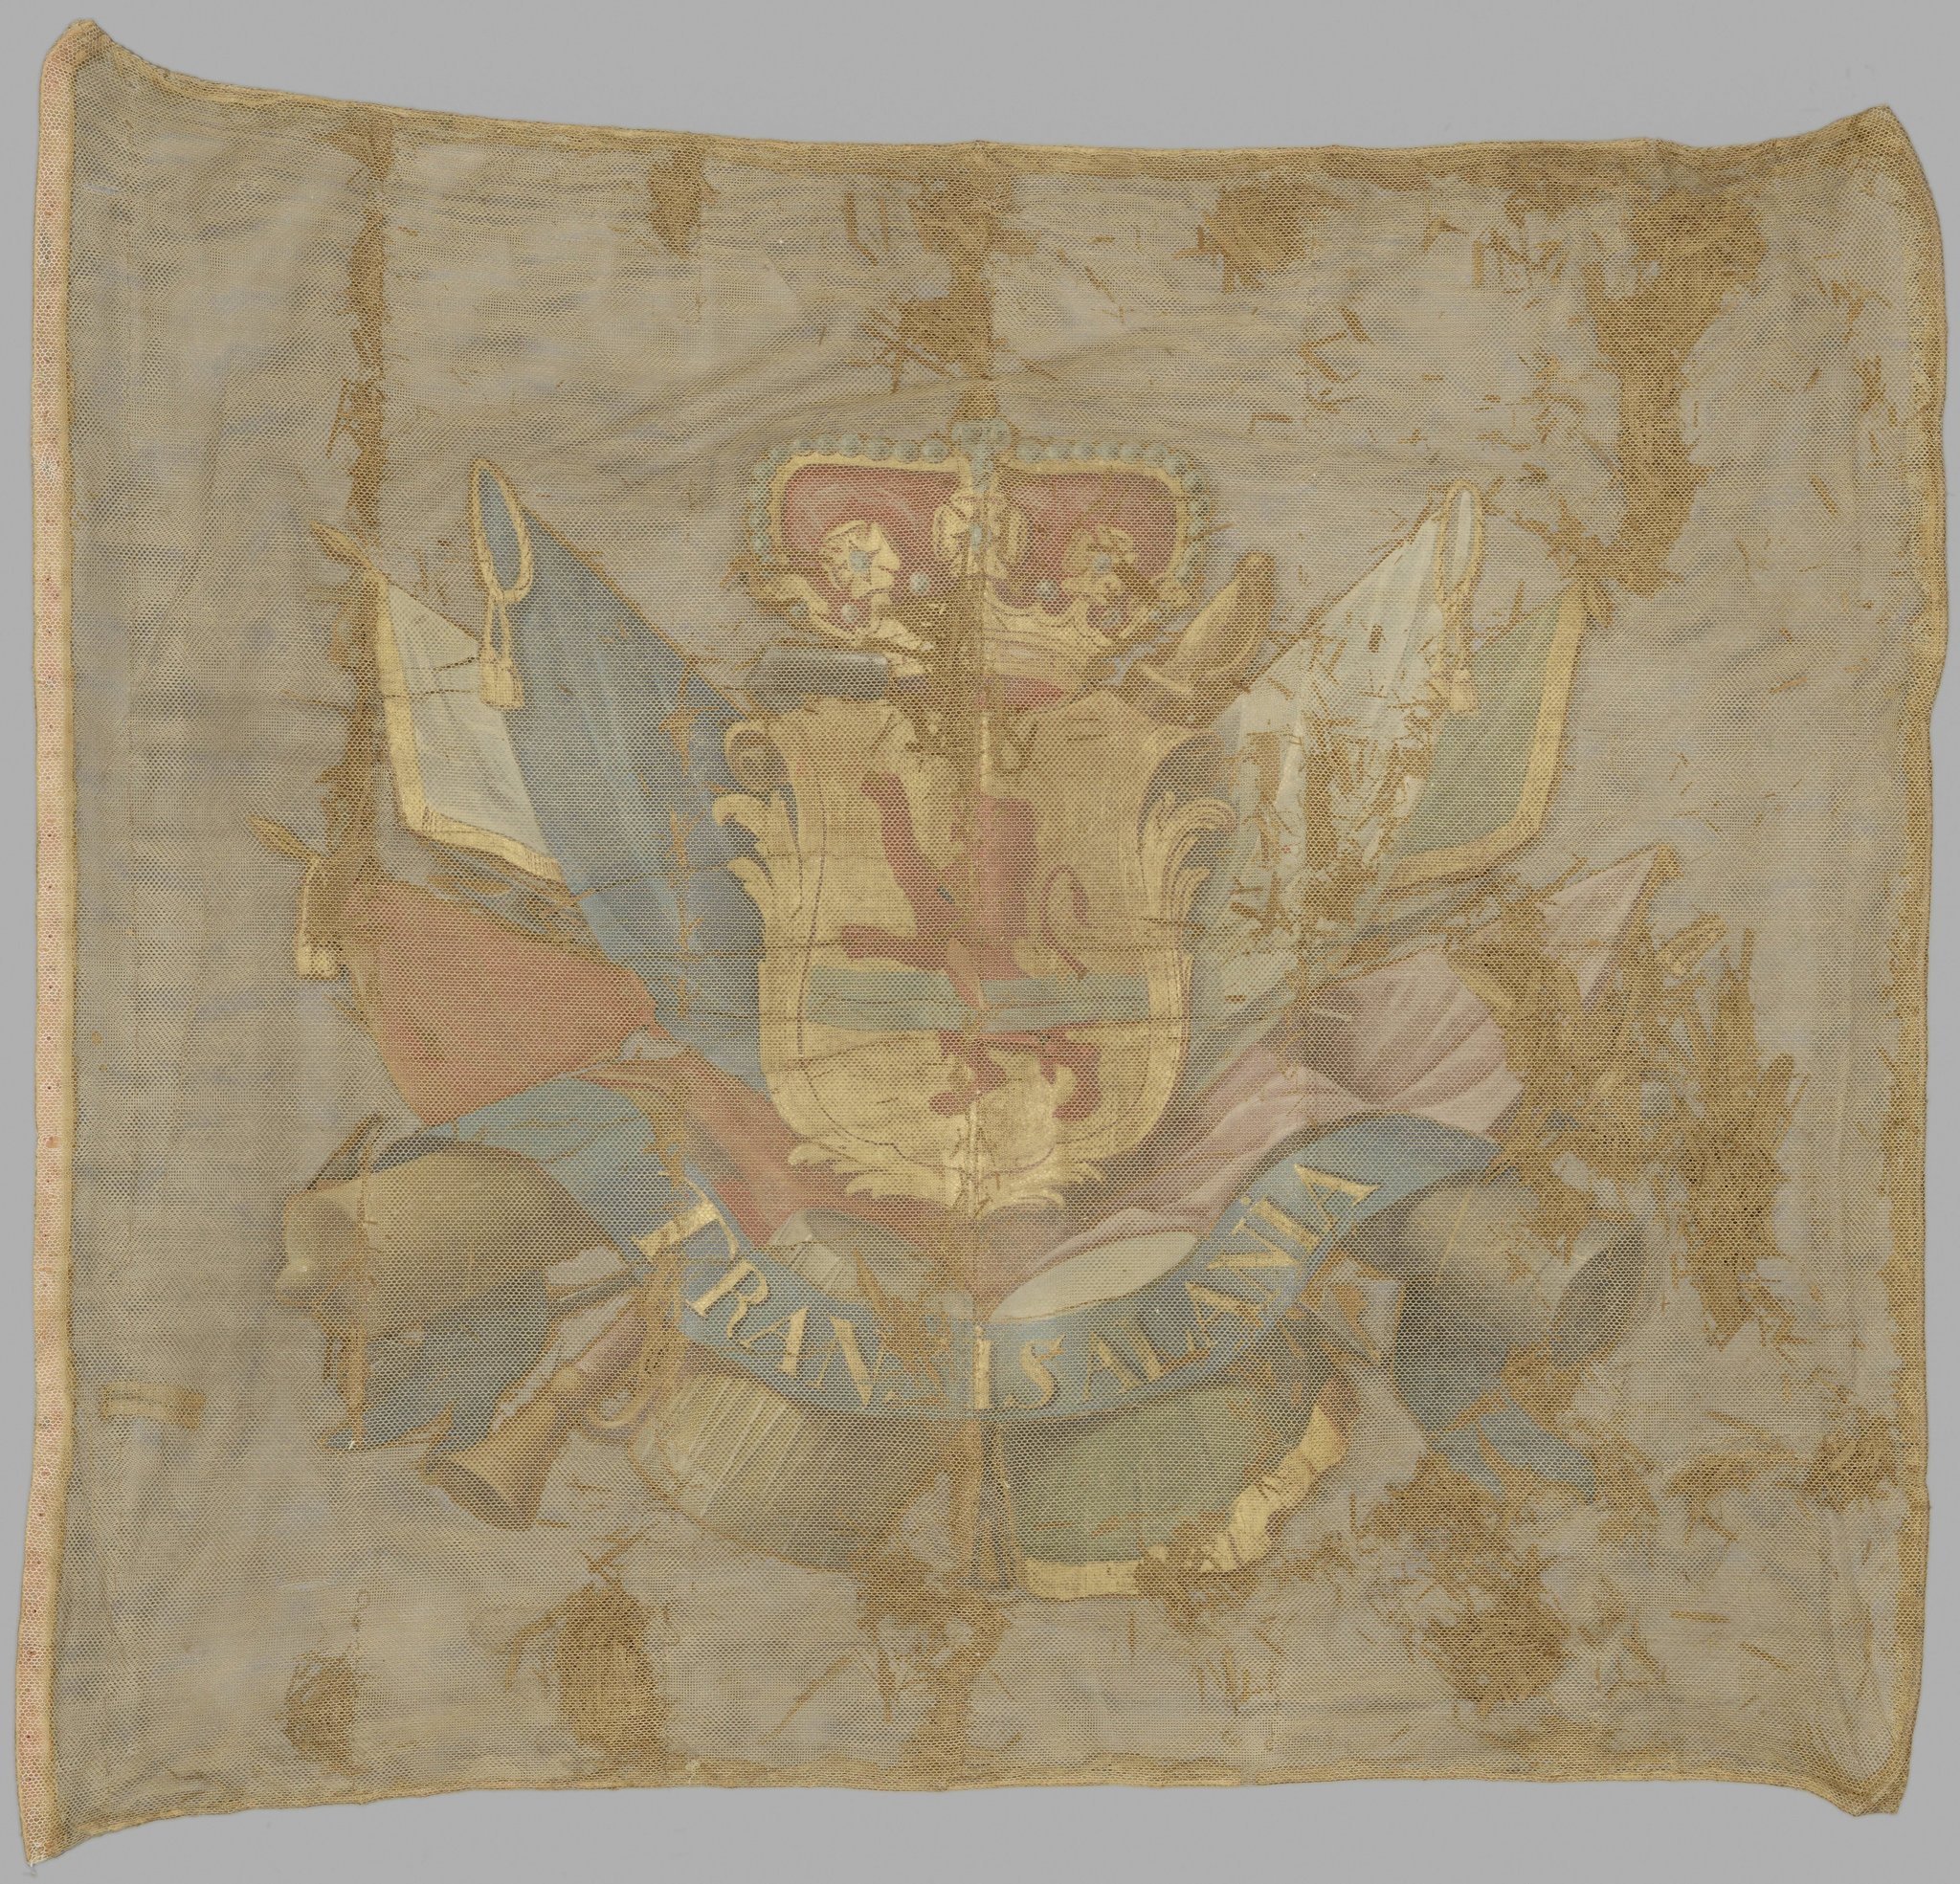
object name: banner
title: Vaandel van één der regimenten op Overijssel (no. 20)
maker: Anonymous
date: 1780-1795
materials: silk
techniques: painted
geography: overijssel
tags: overijssel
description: Ecru, op het midden het wapen van Overijssel, gedekt door een hertogelijke kroon. Het wapen is geplaatst op een trofee van symmetrisch geordende kanonnen, lansen, degens, vaandels, trompetten en trommels. Onder het wapen op blauwe banderol in gouden klassieke kapitalen: TRANSISALANIA. Paradekant identiek, doch in plaats van het wapen van Overijssel het wapen der Republiek, met op de banderol: CONCORDIA RESPARVAE CRESCUNT.